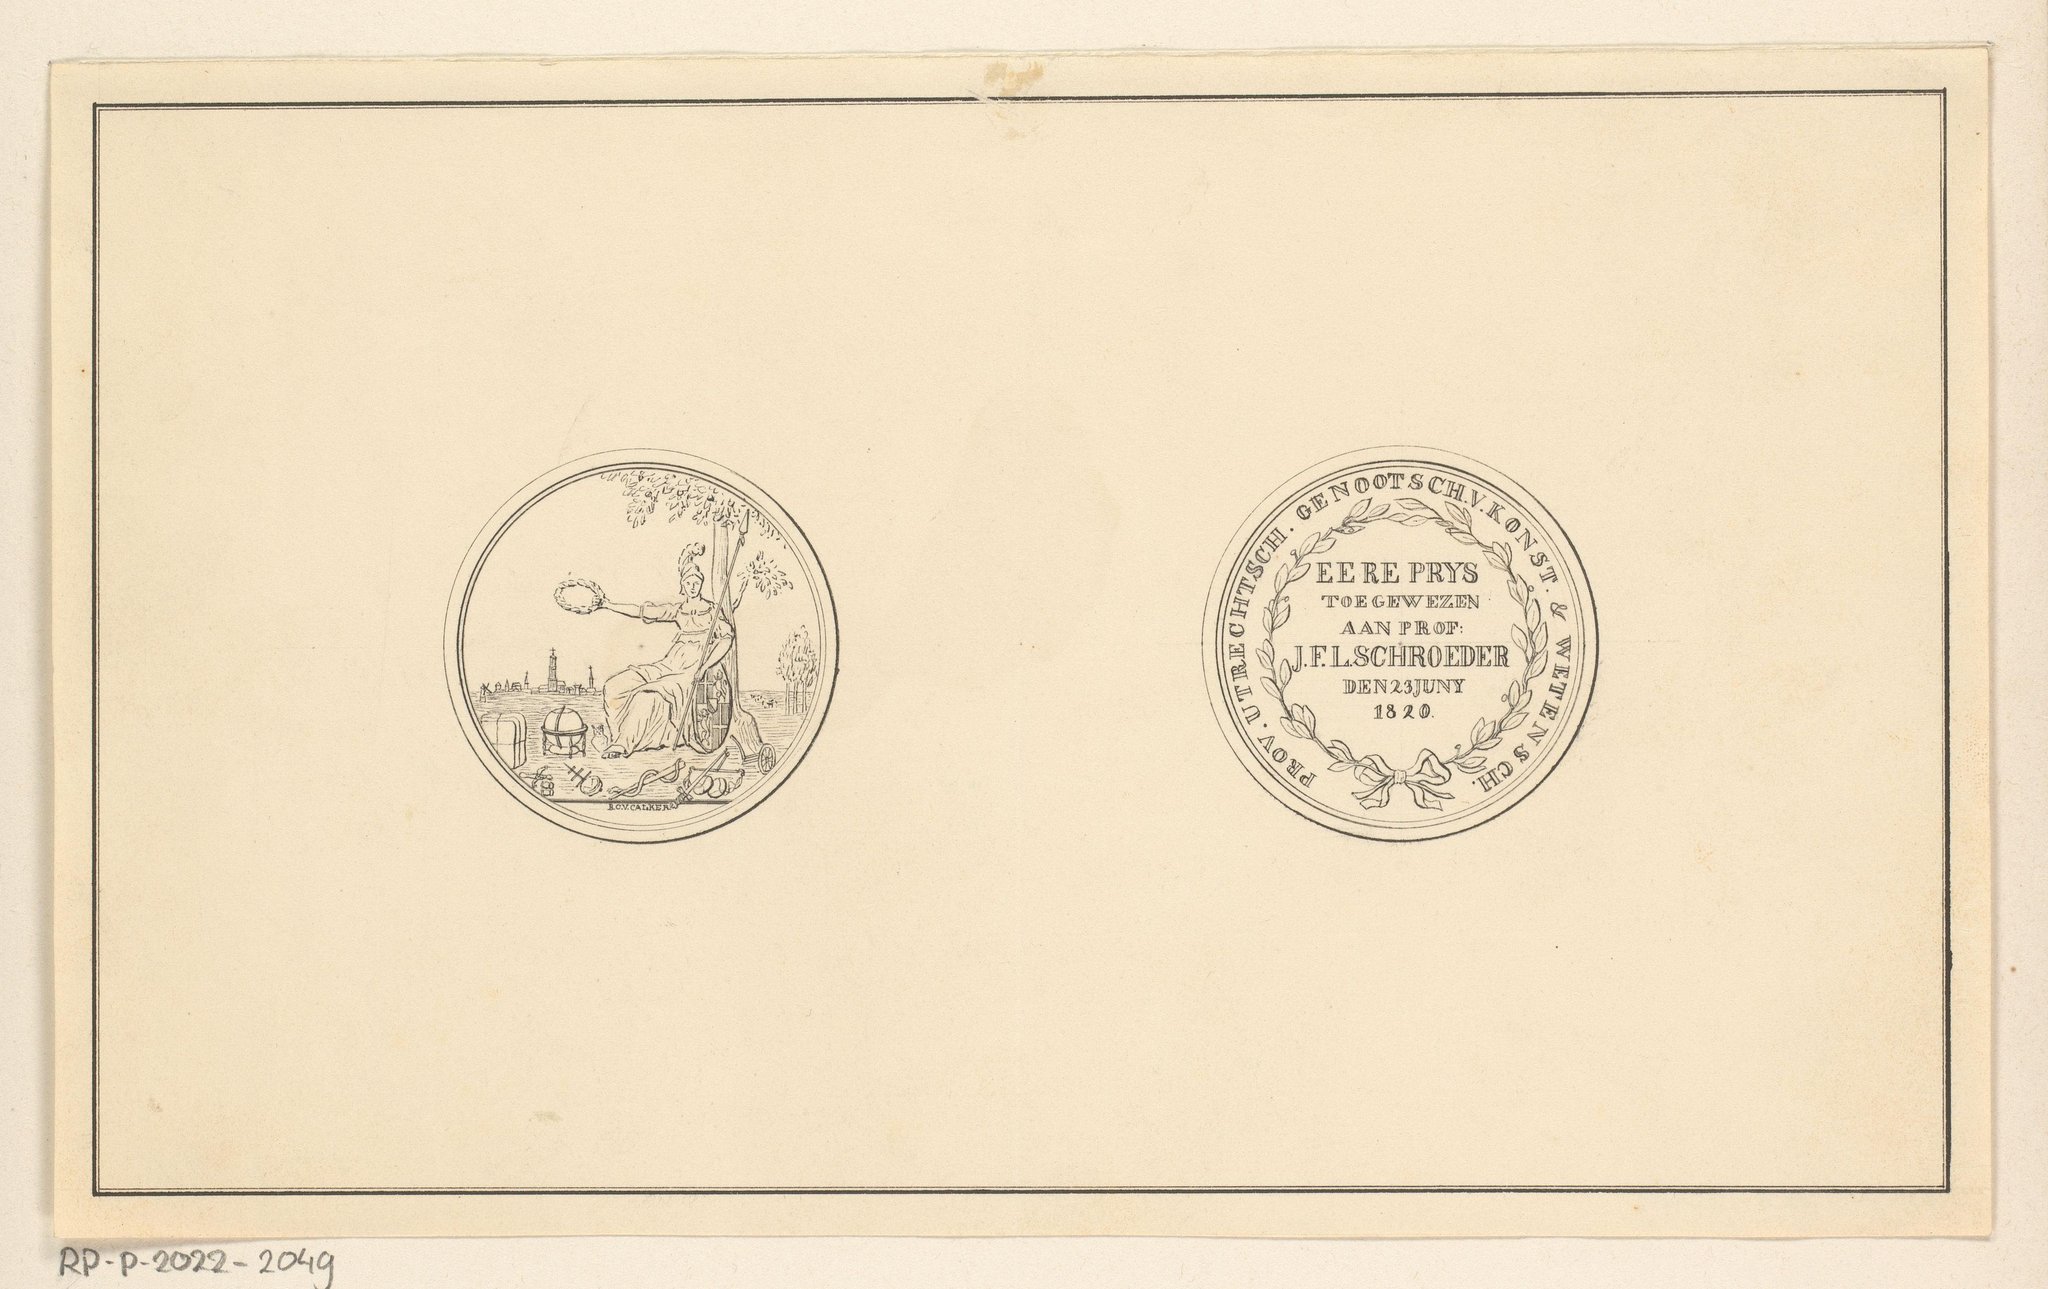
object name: drawing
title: Provinciaal Utrechtsch Genootschap van Kunsten en Wetenschappen penning uitgereikt aan Johannes Frederik Lodewijk Schröder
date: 1820-1825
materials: ink, paper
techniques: pen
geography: zeist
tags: memorial medal